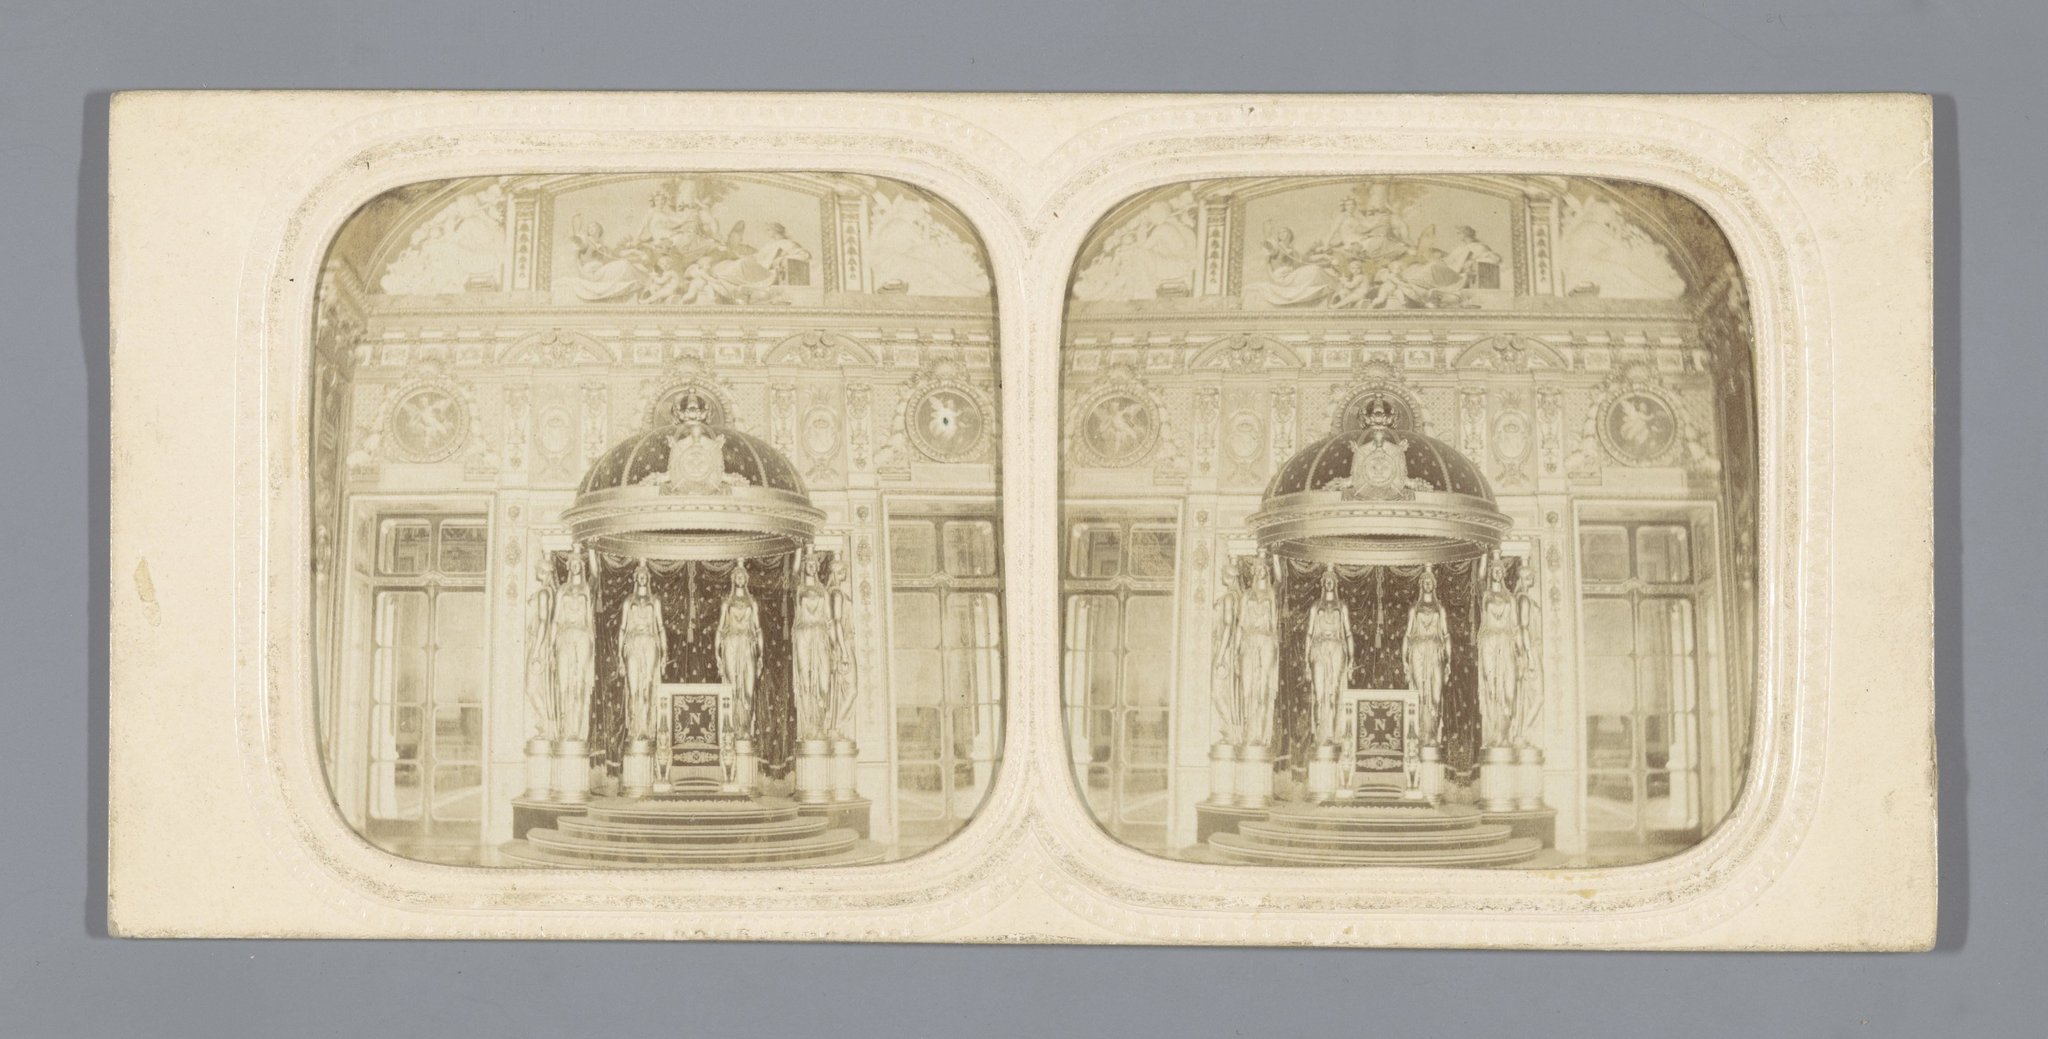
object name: tissue stereograph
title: Palais du Senat, salle du trône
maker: Anonymous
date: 1855-1875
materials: cardboard, paper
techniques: albumen print, hand coloring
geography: paris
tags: throne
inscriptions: inscription: ‘cG100 [onz]’, retailer's mark: ‘Feldbrugge & Co./ Groningen’